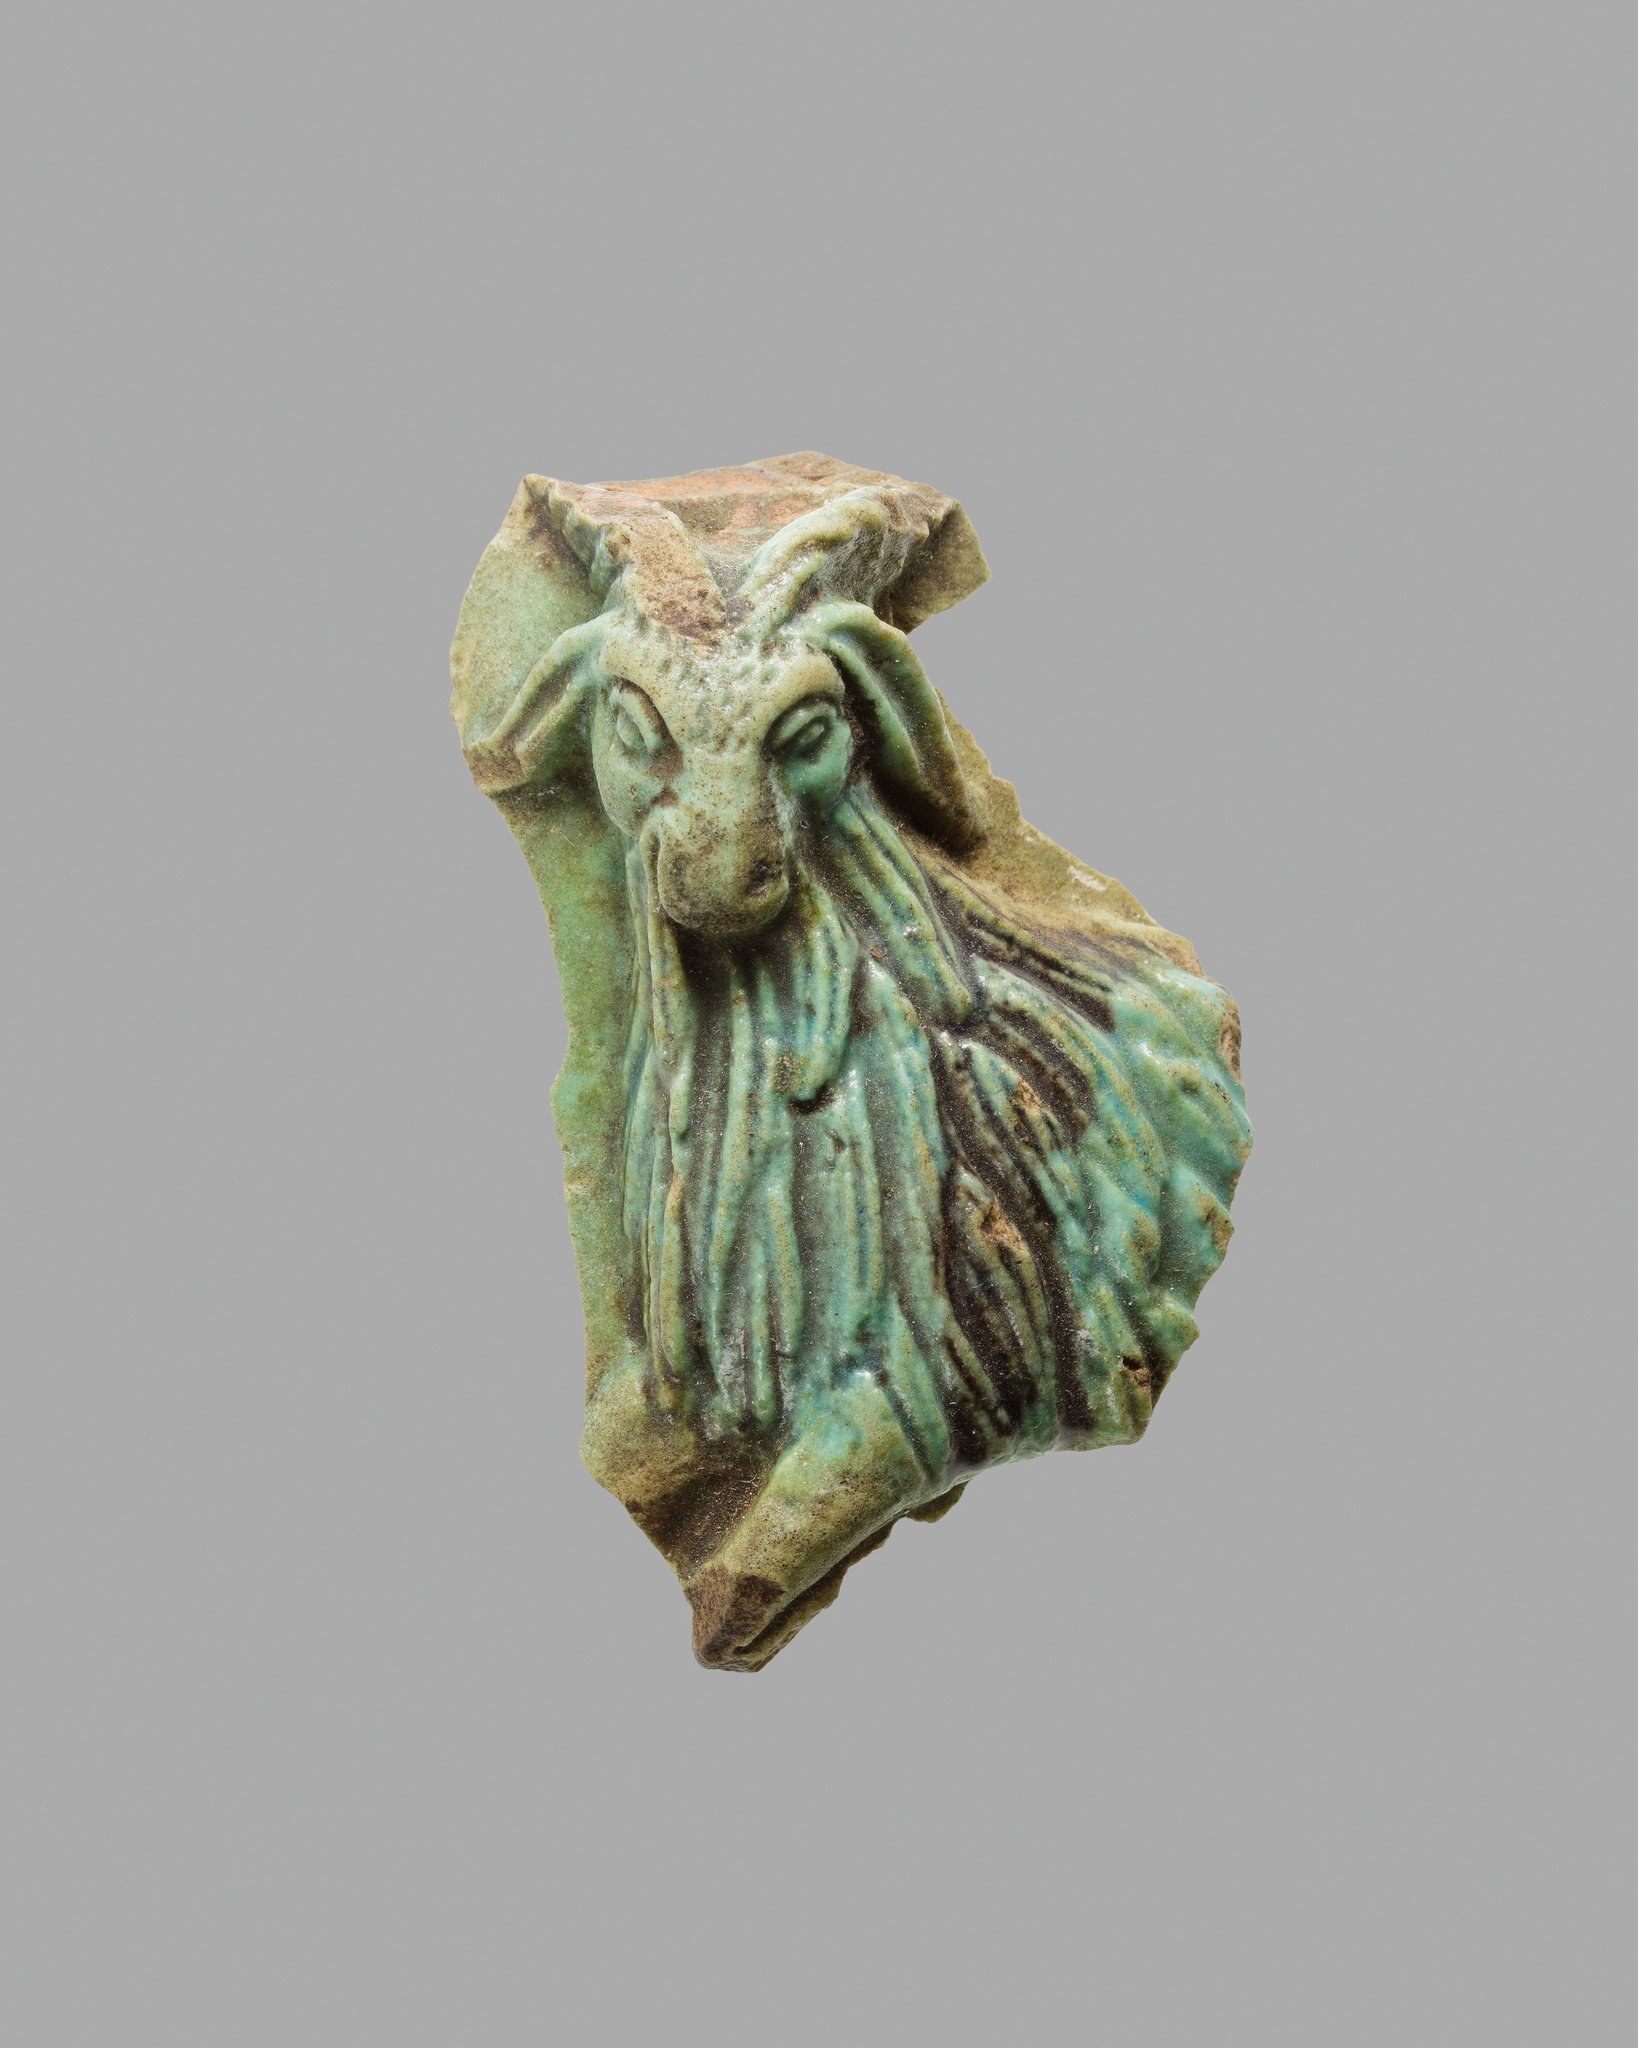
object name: jar, goat relief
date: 101-200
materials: faience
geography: egypt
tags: goats